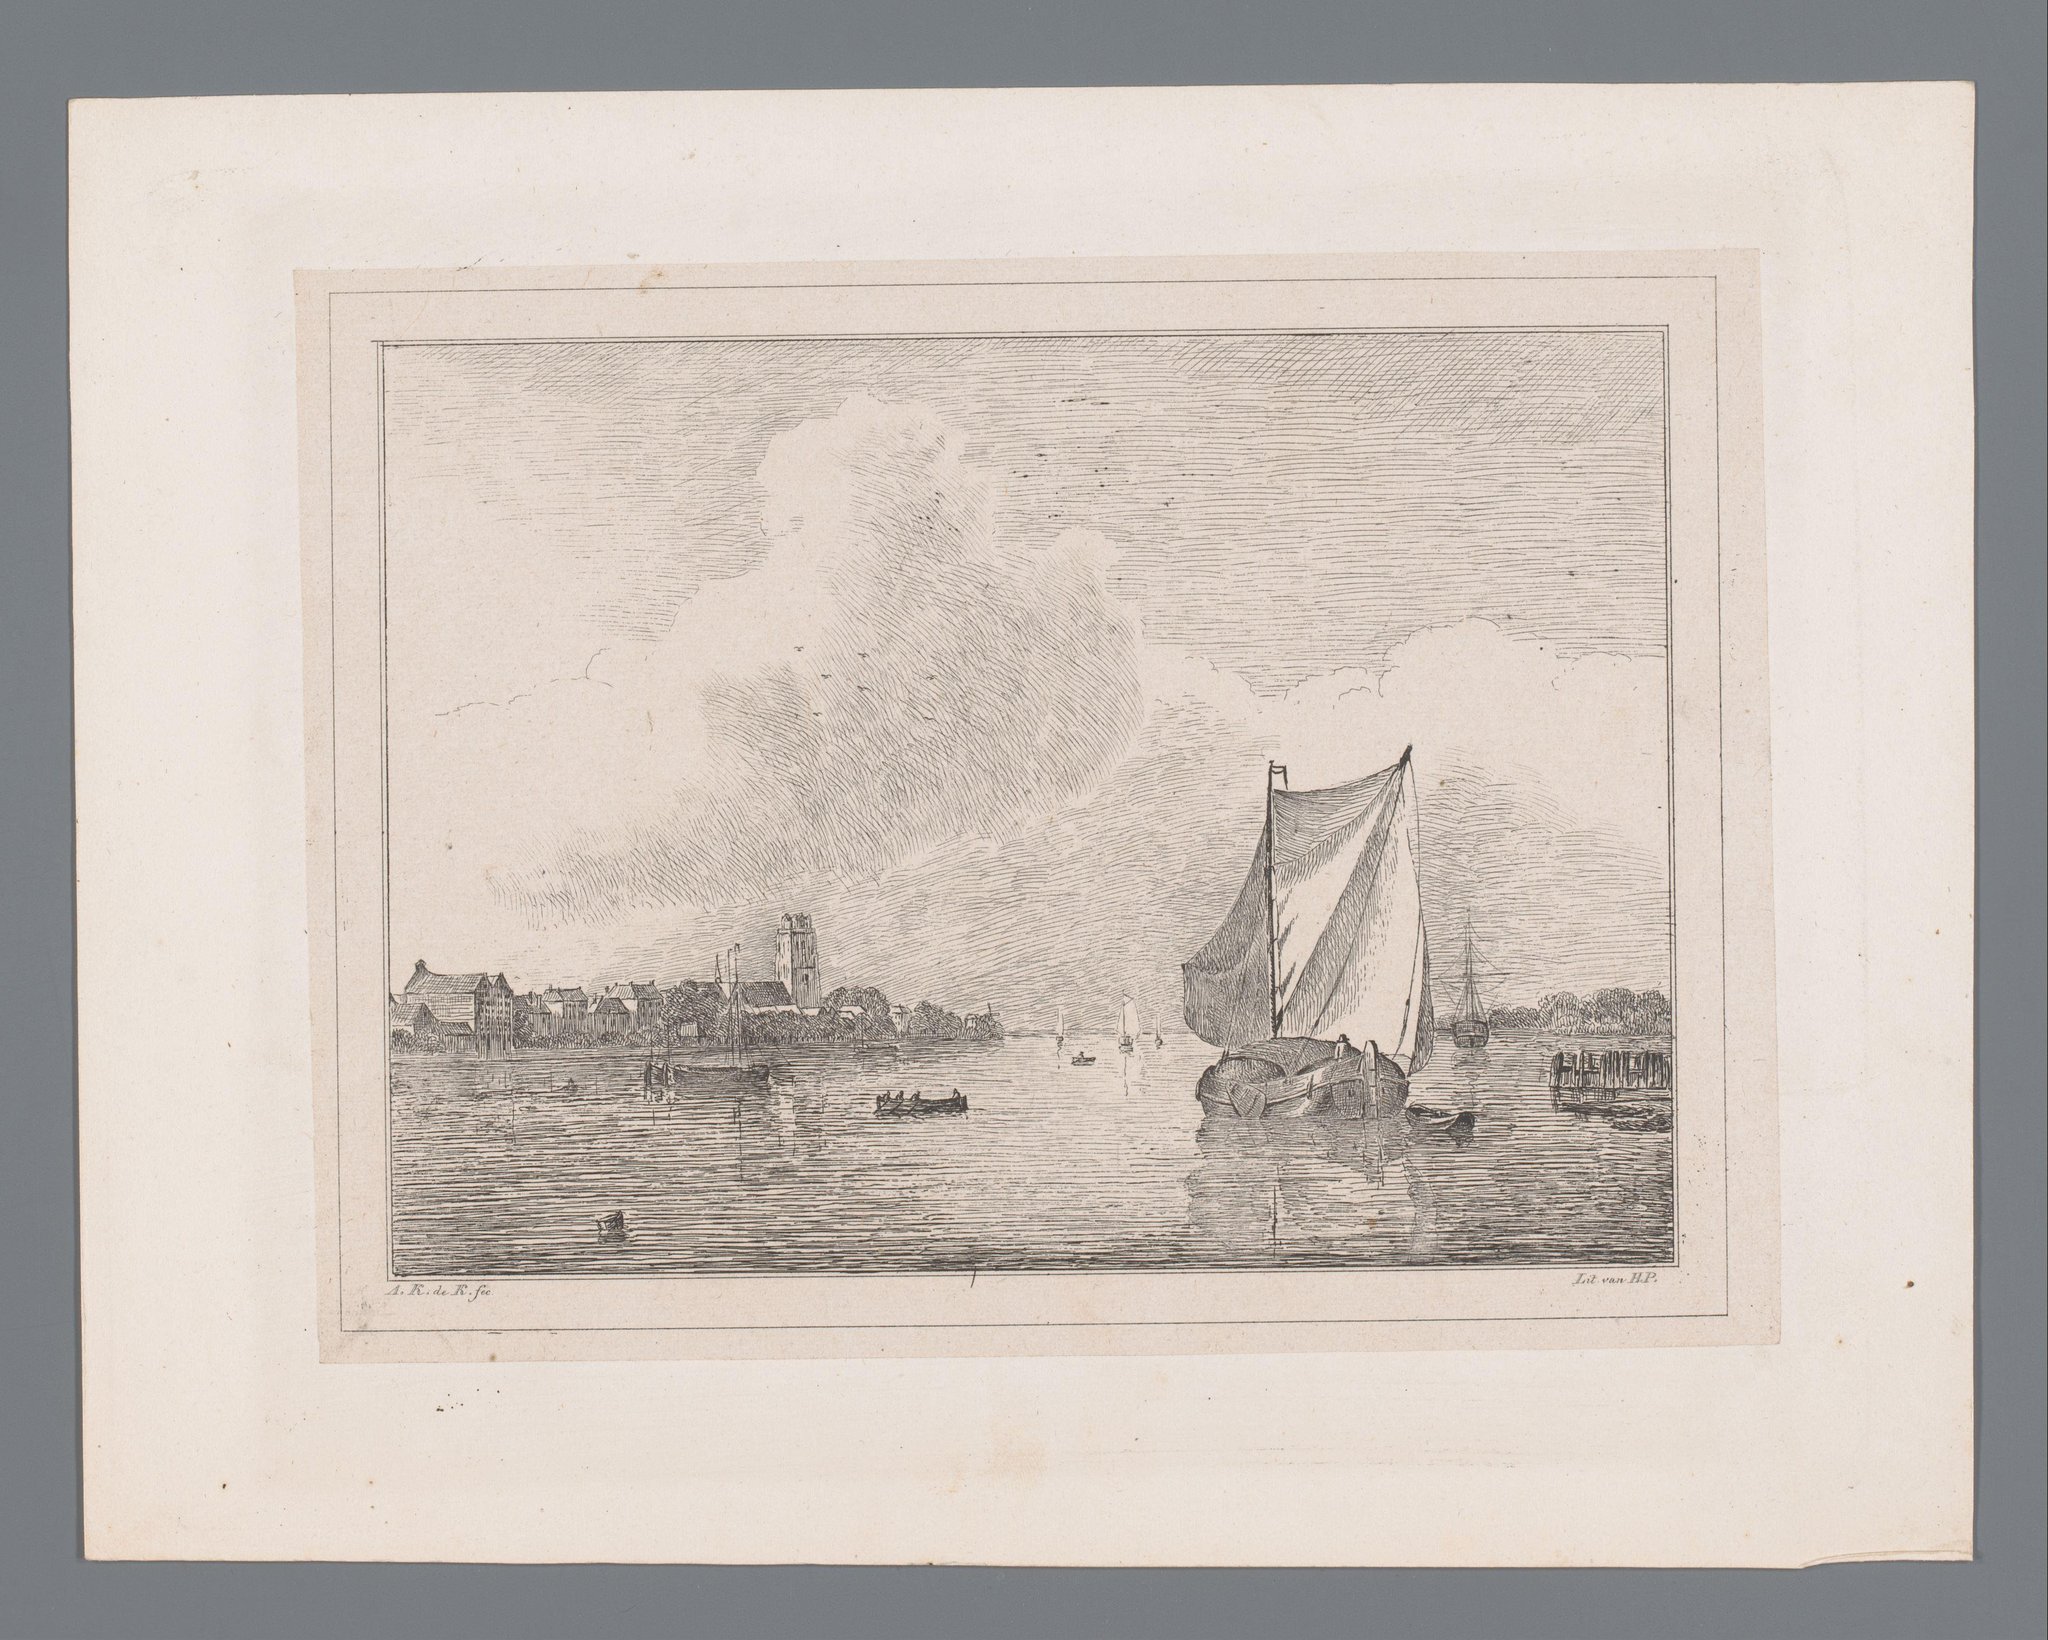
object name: print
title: Gezicht op Dordrecht vanaf het water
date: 1839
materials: paper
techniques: etching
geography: dordrecht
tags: city-view, and landscape with man-made constructions, ships (in general), dordrecht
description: Op het water varen verschillende soorten boten. Links ligt de stad met de toren van de Grote Kerk.